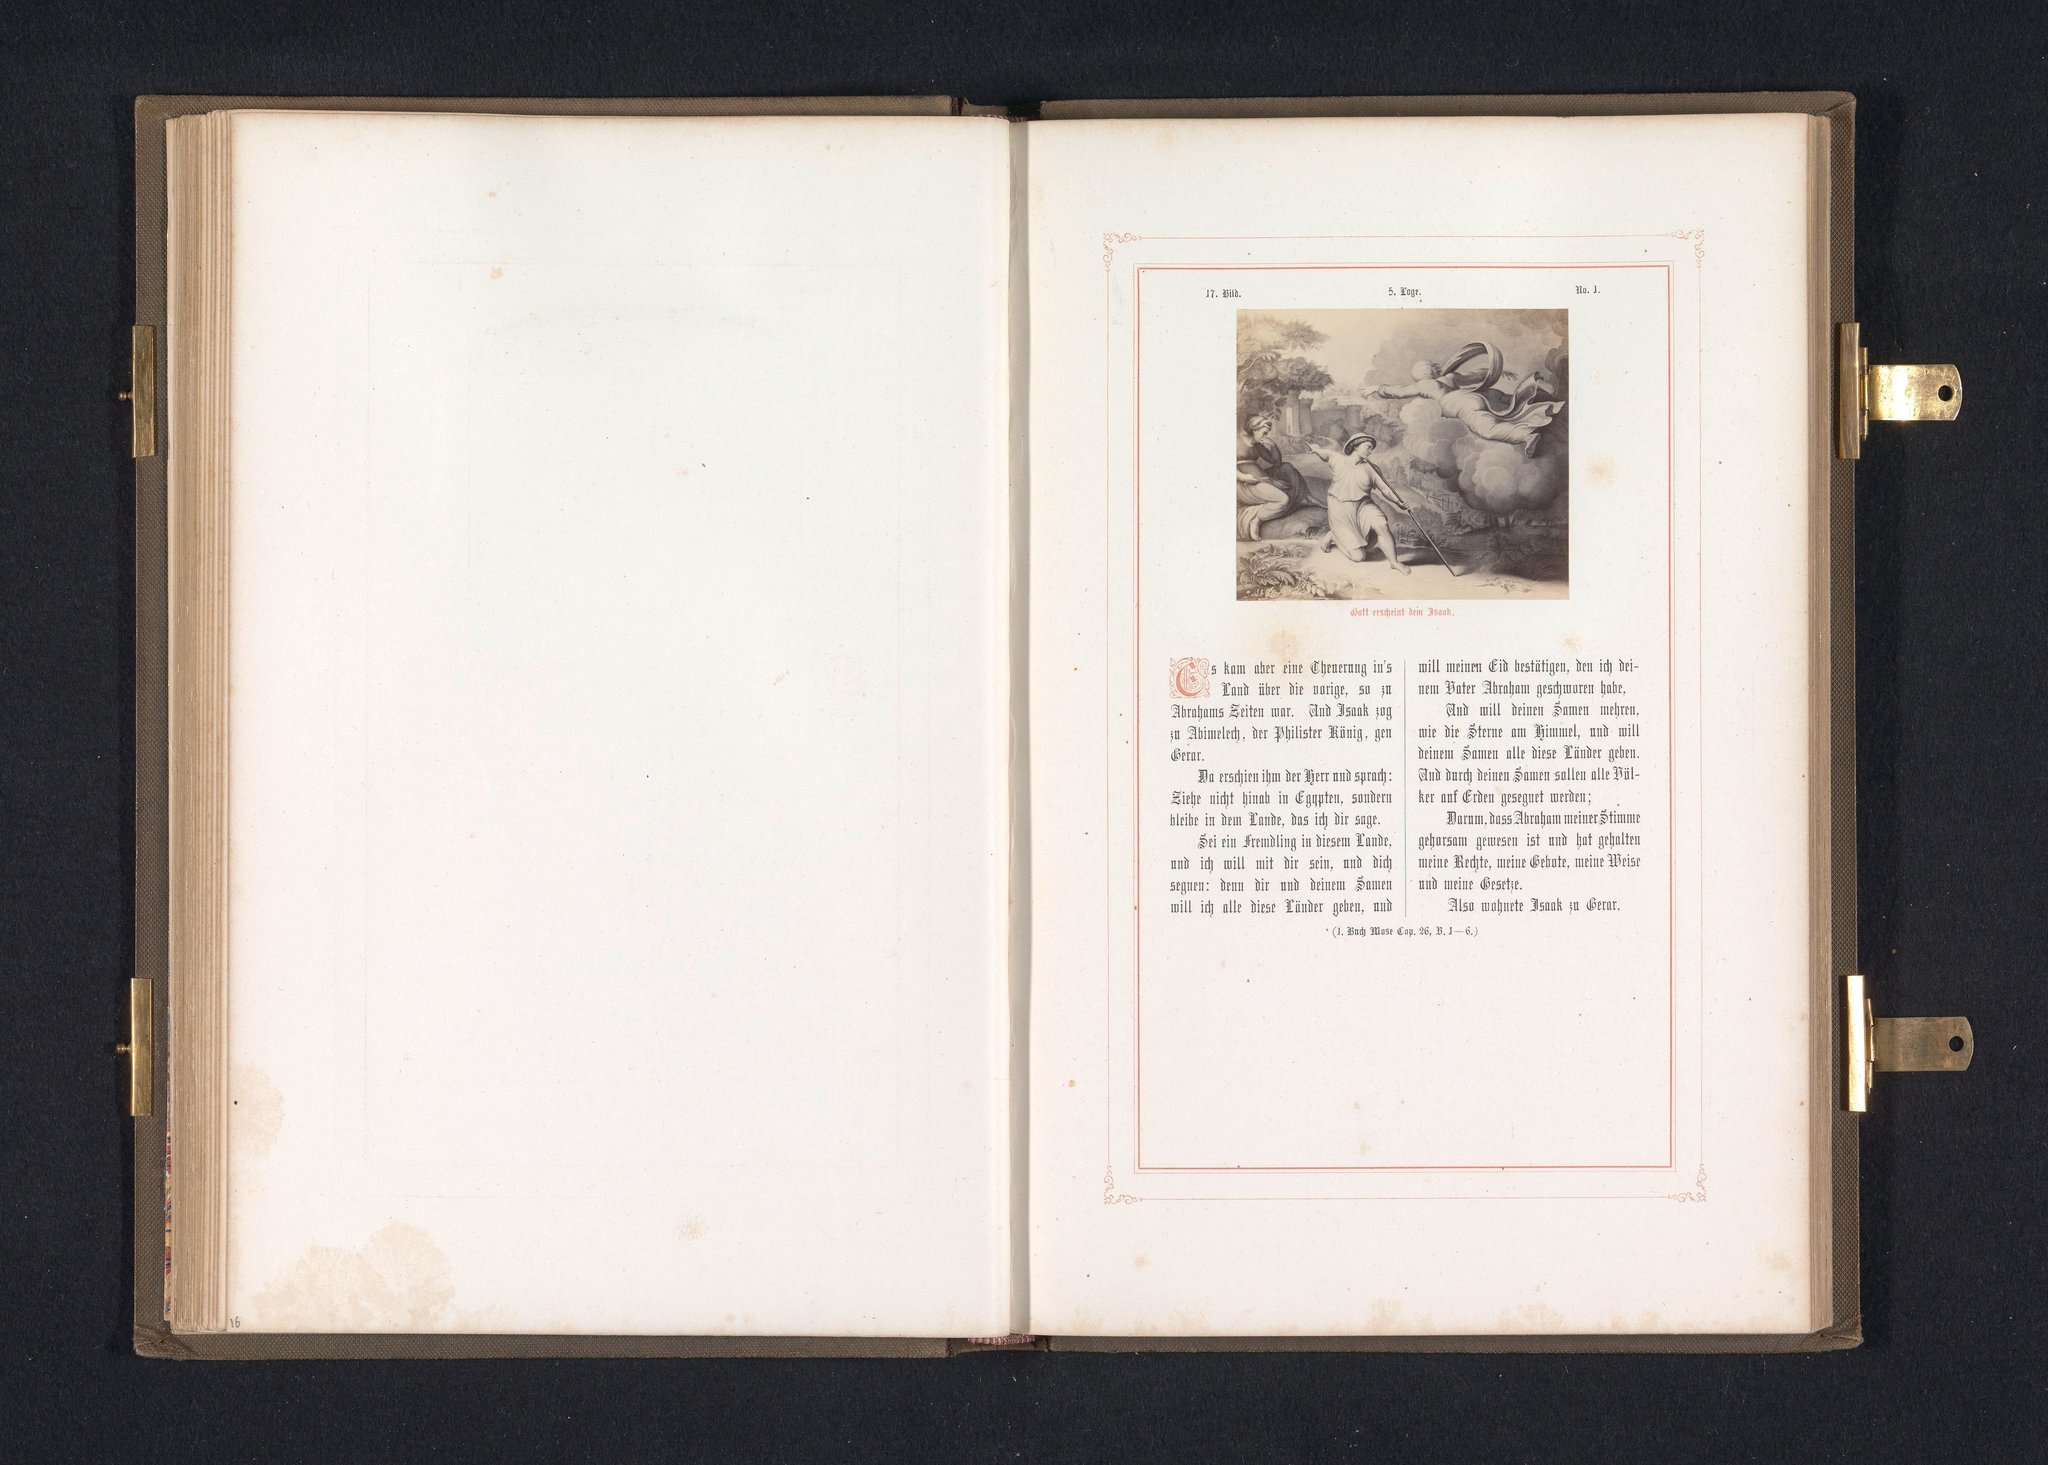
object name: photograph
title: Fotoreproductie van een prent naar een fresco van God die aan Isaak verschijnt door Rafaël voor de loggia's in het Vaticaan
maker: gustav schauer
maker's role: painter, publisher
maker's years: 1826-1902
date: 1851-1861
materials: photographic support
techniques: albumen print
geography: berlin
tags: god appears to isaac (journey to beersheba)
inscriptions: inscription: ‘17. Bild. 5. Loge. No. 1.’